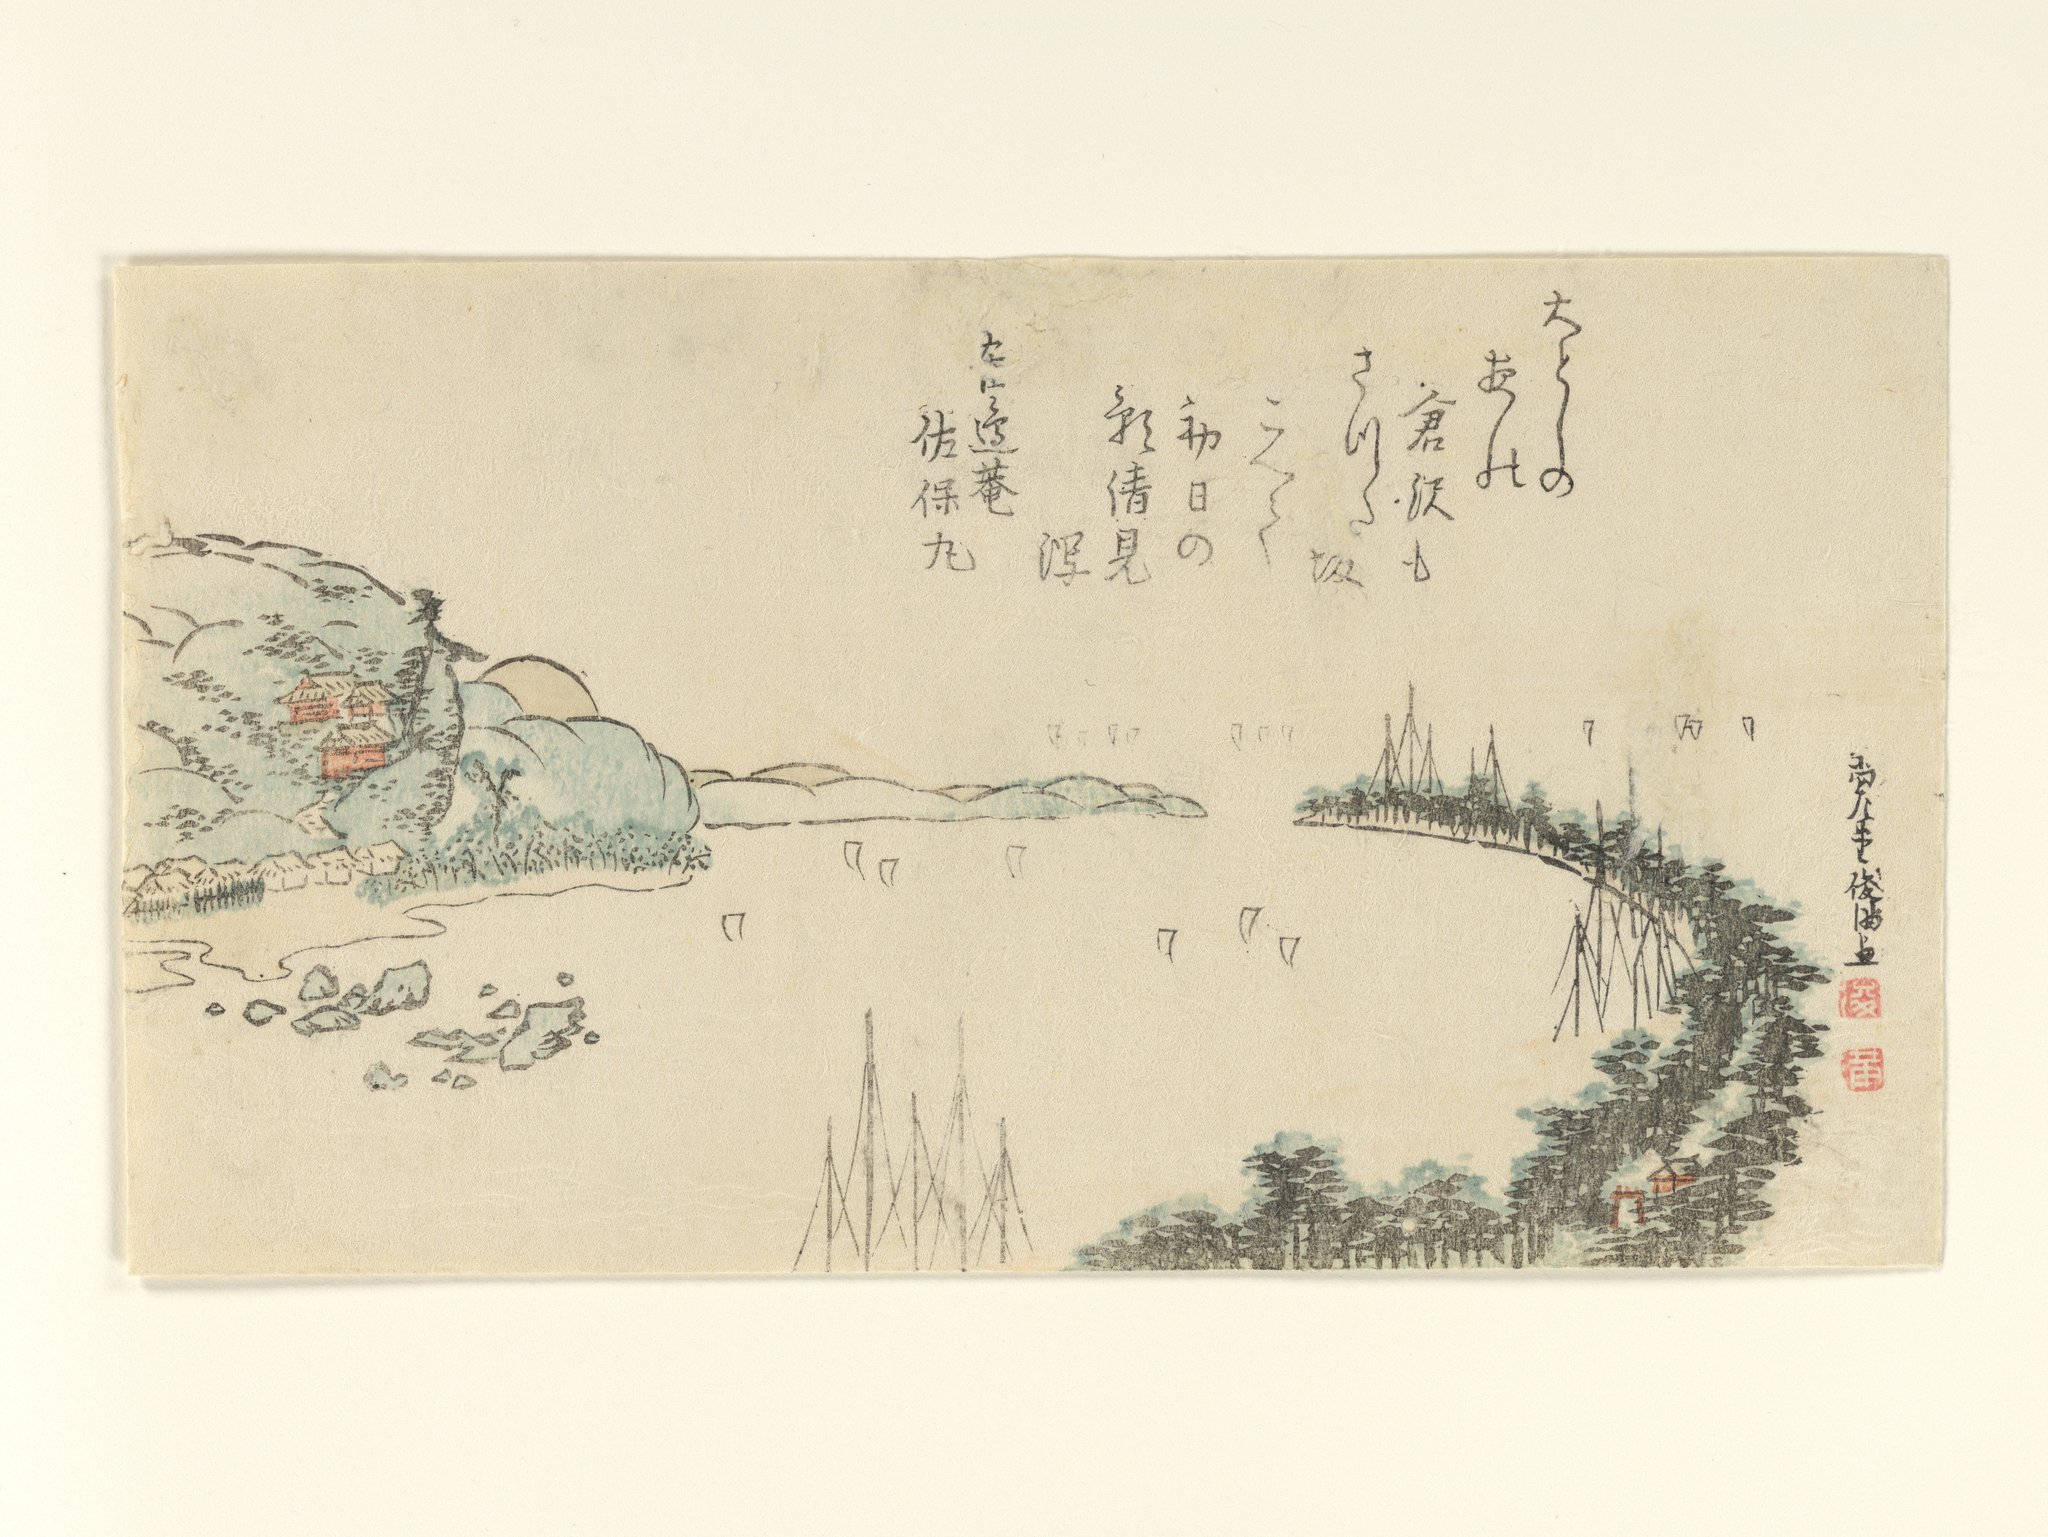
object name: print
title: Harbor Scene Near Kamakura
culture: japanese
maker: kubo shunman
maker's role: artist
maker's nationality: japanese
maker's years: 1757-1820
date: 1797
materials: ink, paper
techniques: surimono, woodblock print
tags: landscapes